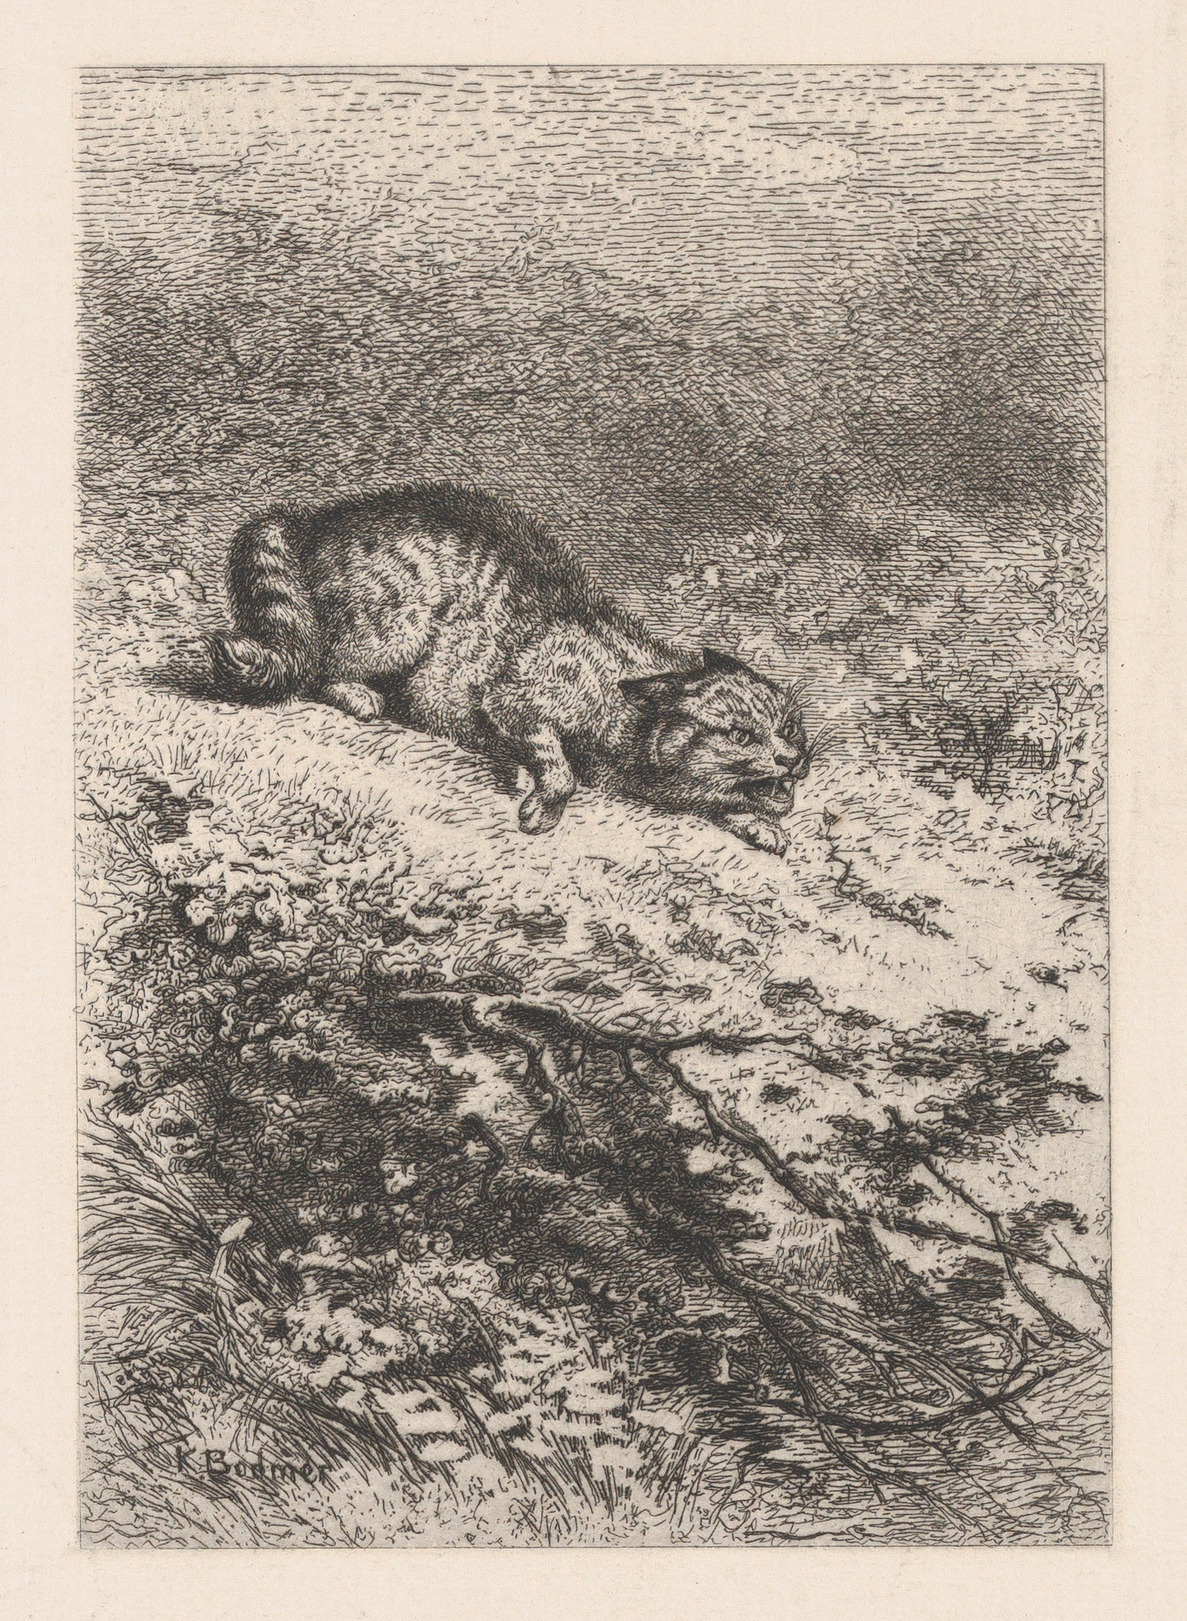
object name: print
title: Wild Cat, from "Eaux-Fortes Animaux & Paysages"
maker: karl bodmer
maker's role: artist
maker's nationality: swiss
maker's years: 1809-1893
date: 1860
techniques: etching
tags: cats